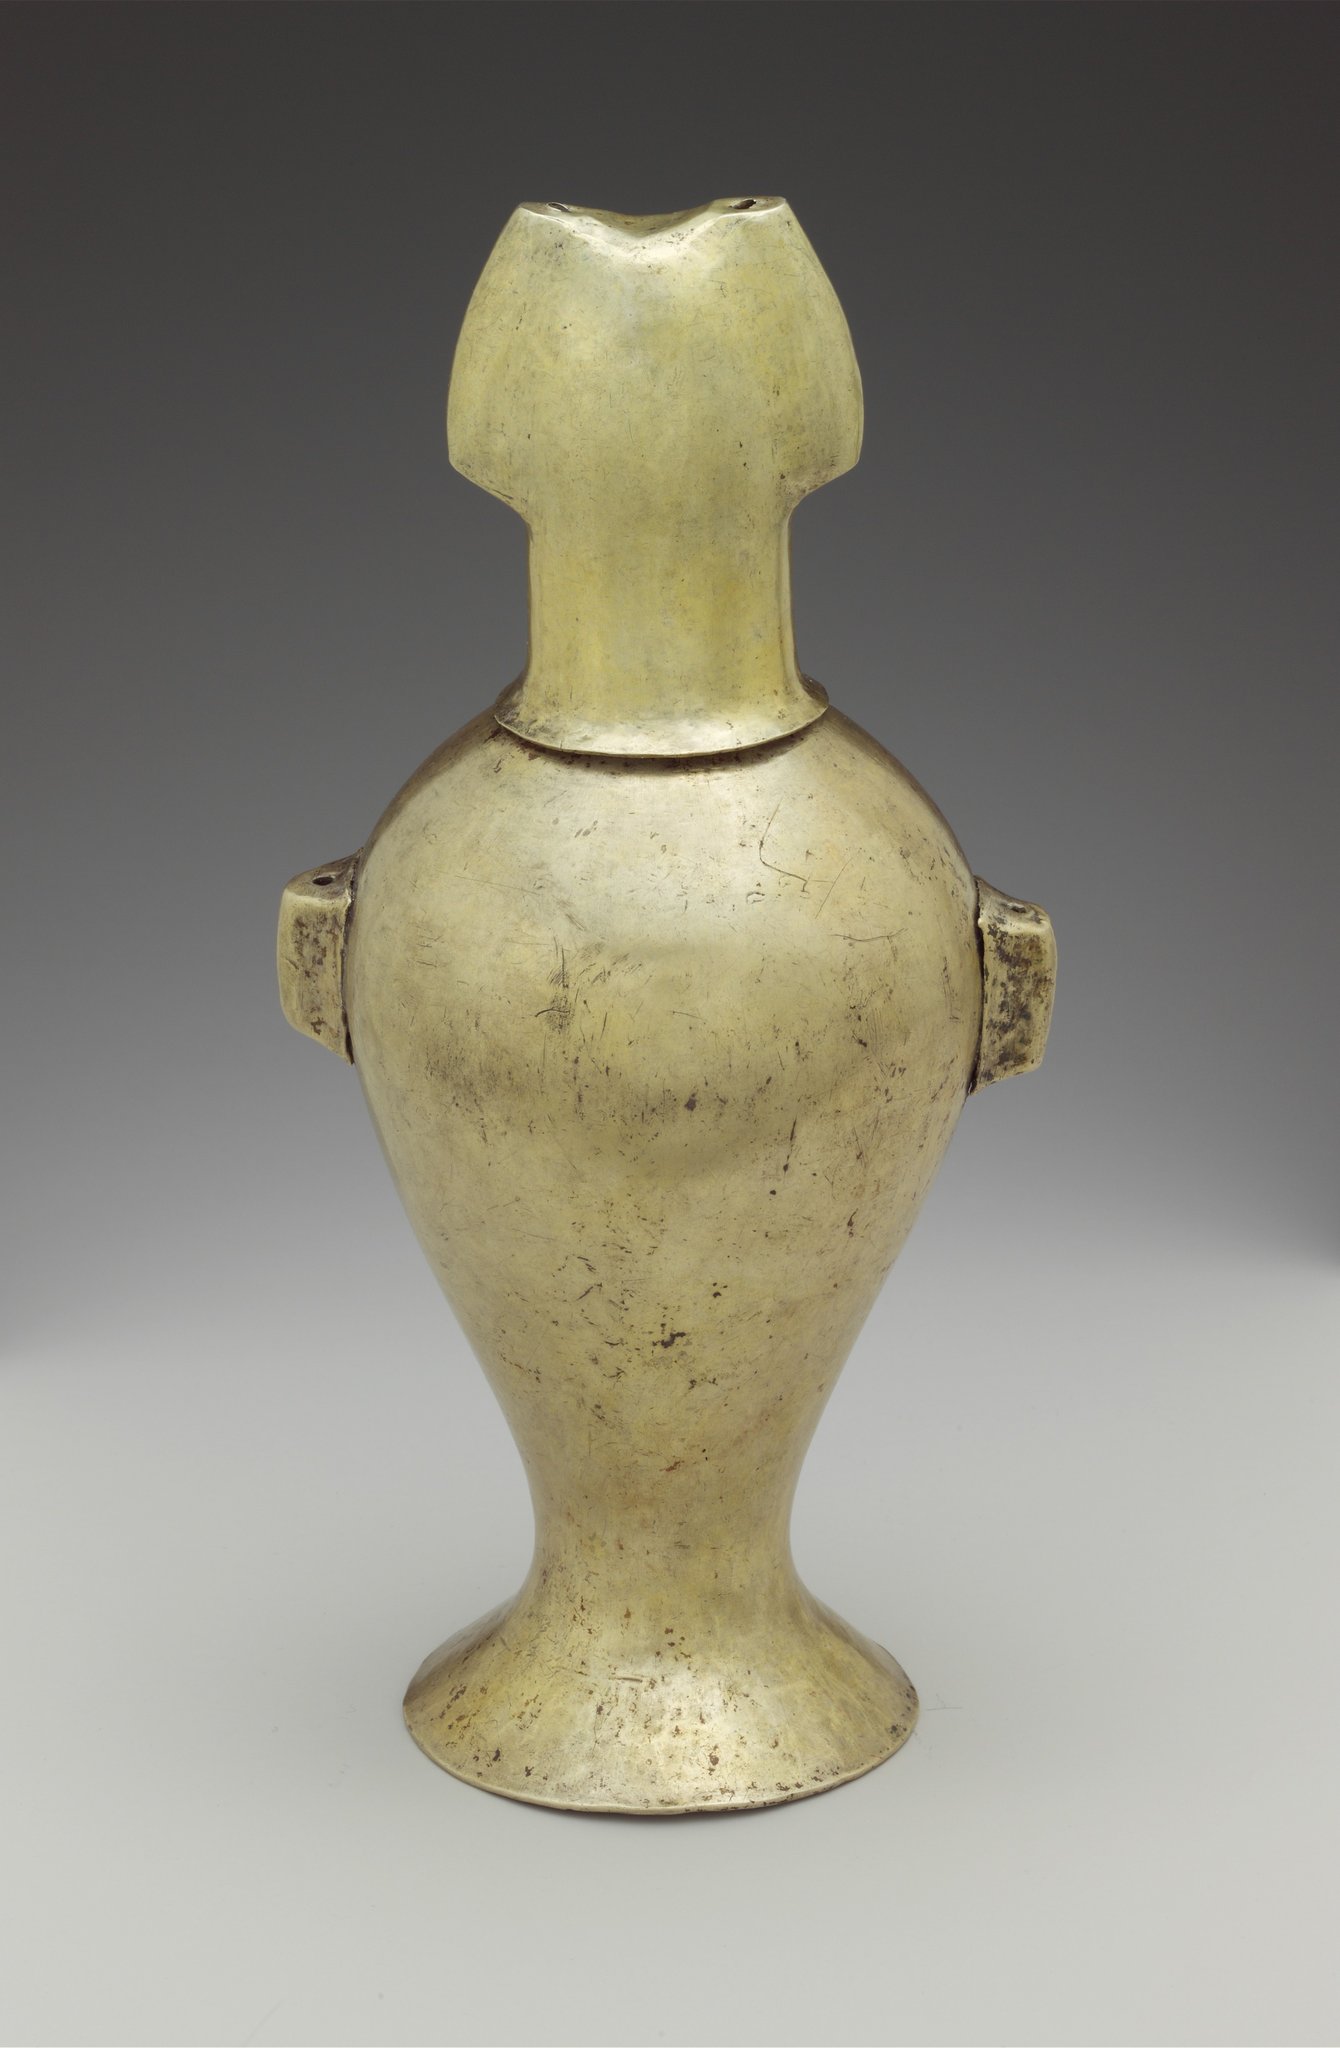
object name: vase with lid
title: Electrum vase with lid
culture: anatolian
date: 2300-2000 BCE